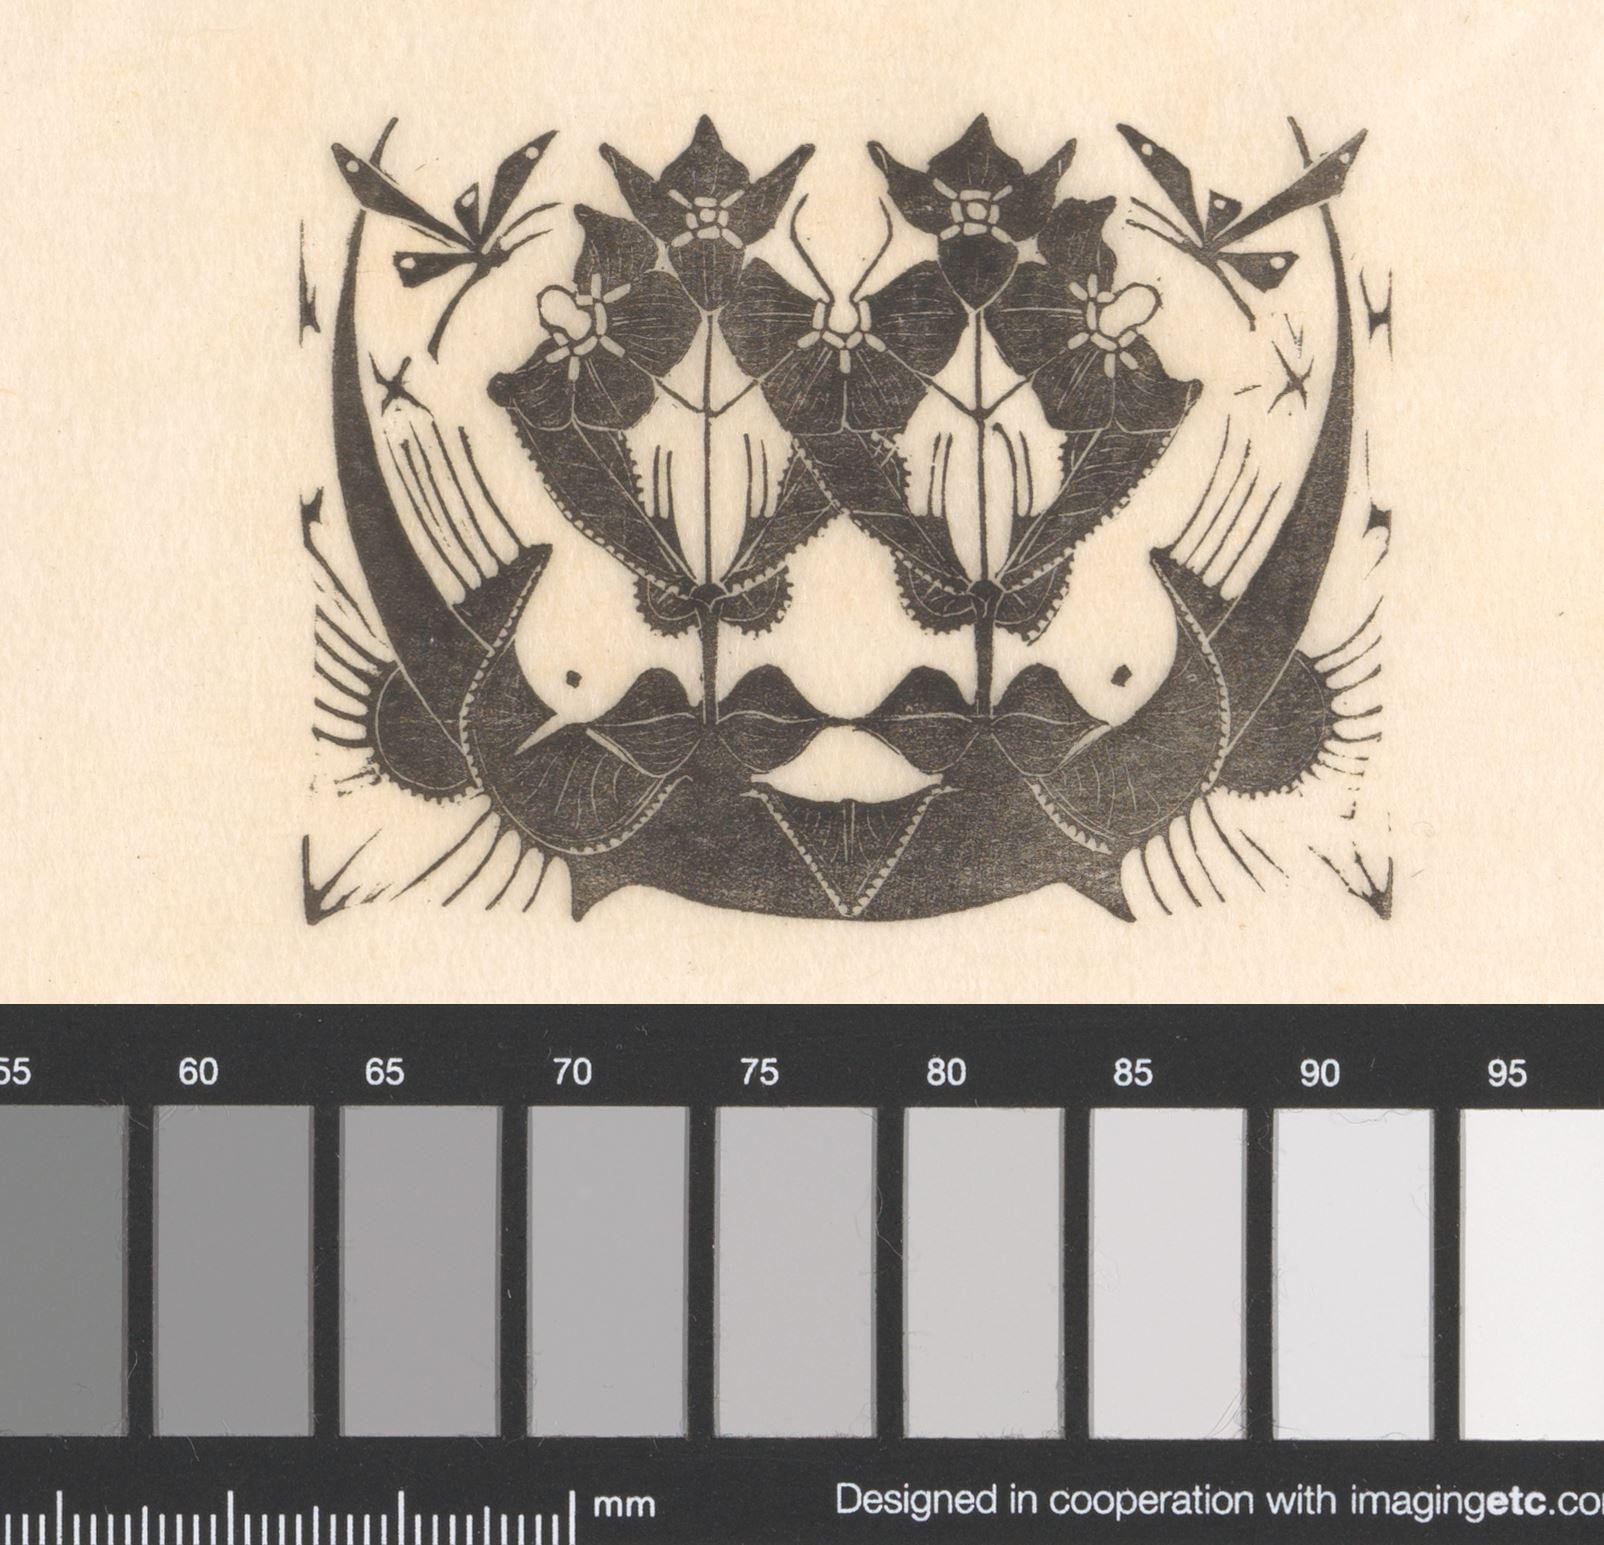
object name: vignette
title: Vignet met maansikkel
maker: mathieu lauweriks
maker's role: designer, draughtsman, print maker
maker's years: 1864-1932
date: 1897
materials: paper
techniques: woodcut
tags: insects: butterfly, moon as celestial body, flowers ~ ornament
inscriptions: collector's mark: Lugt 2228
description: Prent mogelijk gebruikt voor: Architectura. Ter herdenking van den 70n geboortedag v. Dr. P.J.H. Cuypers, Amsterdam, 16 mei 1897. Maassluis: Van der Endt, 1897, jrg. 5, no. 20.